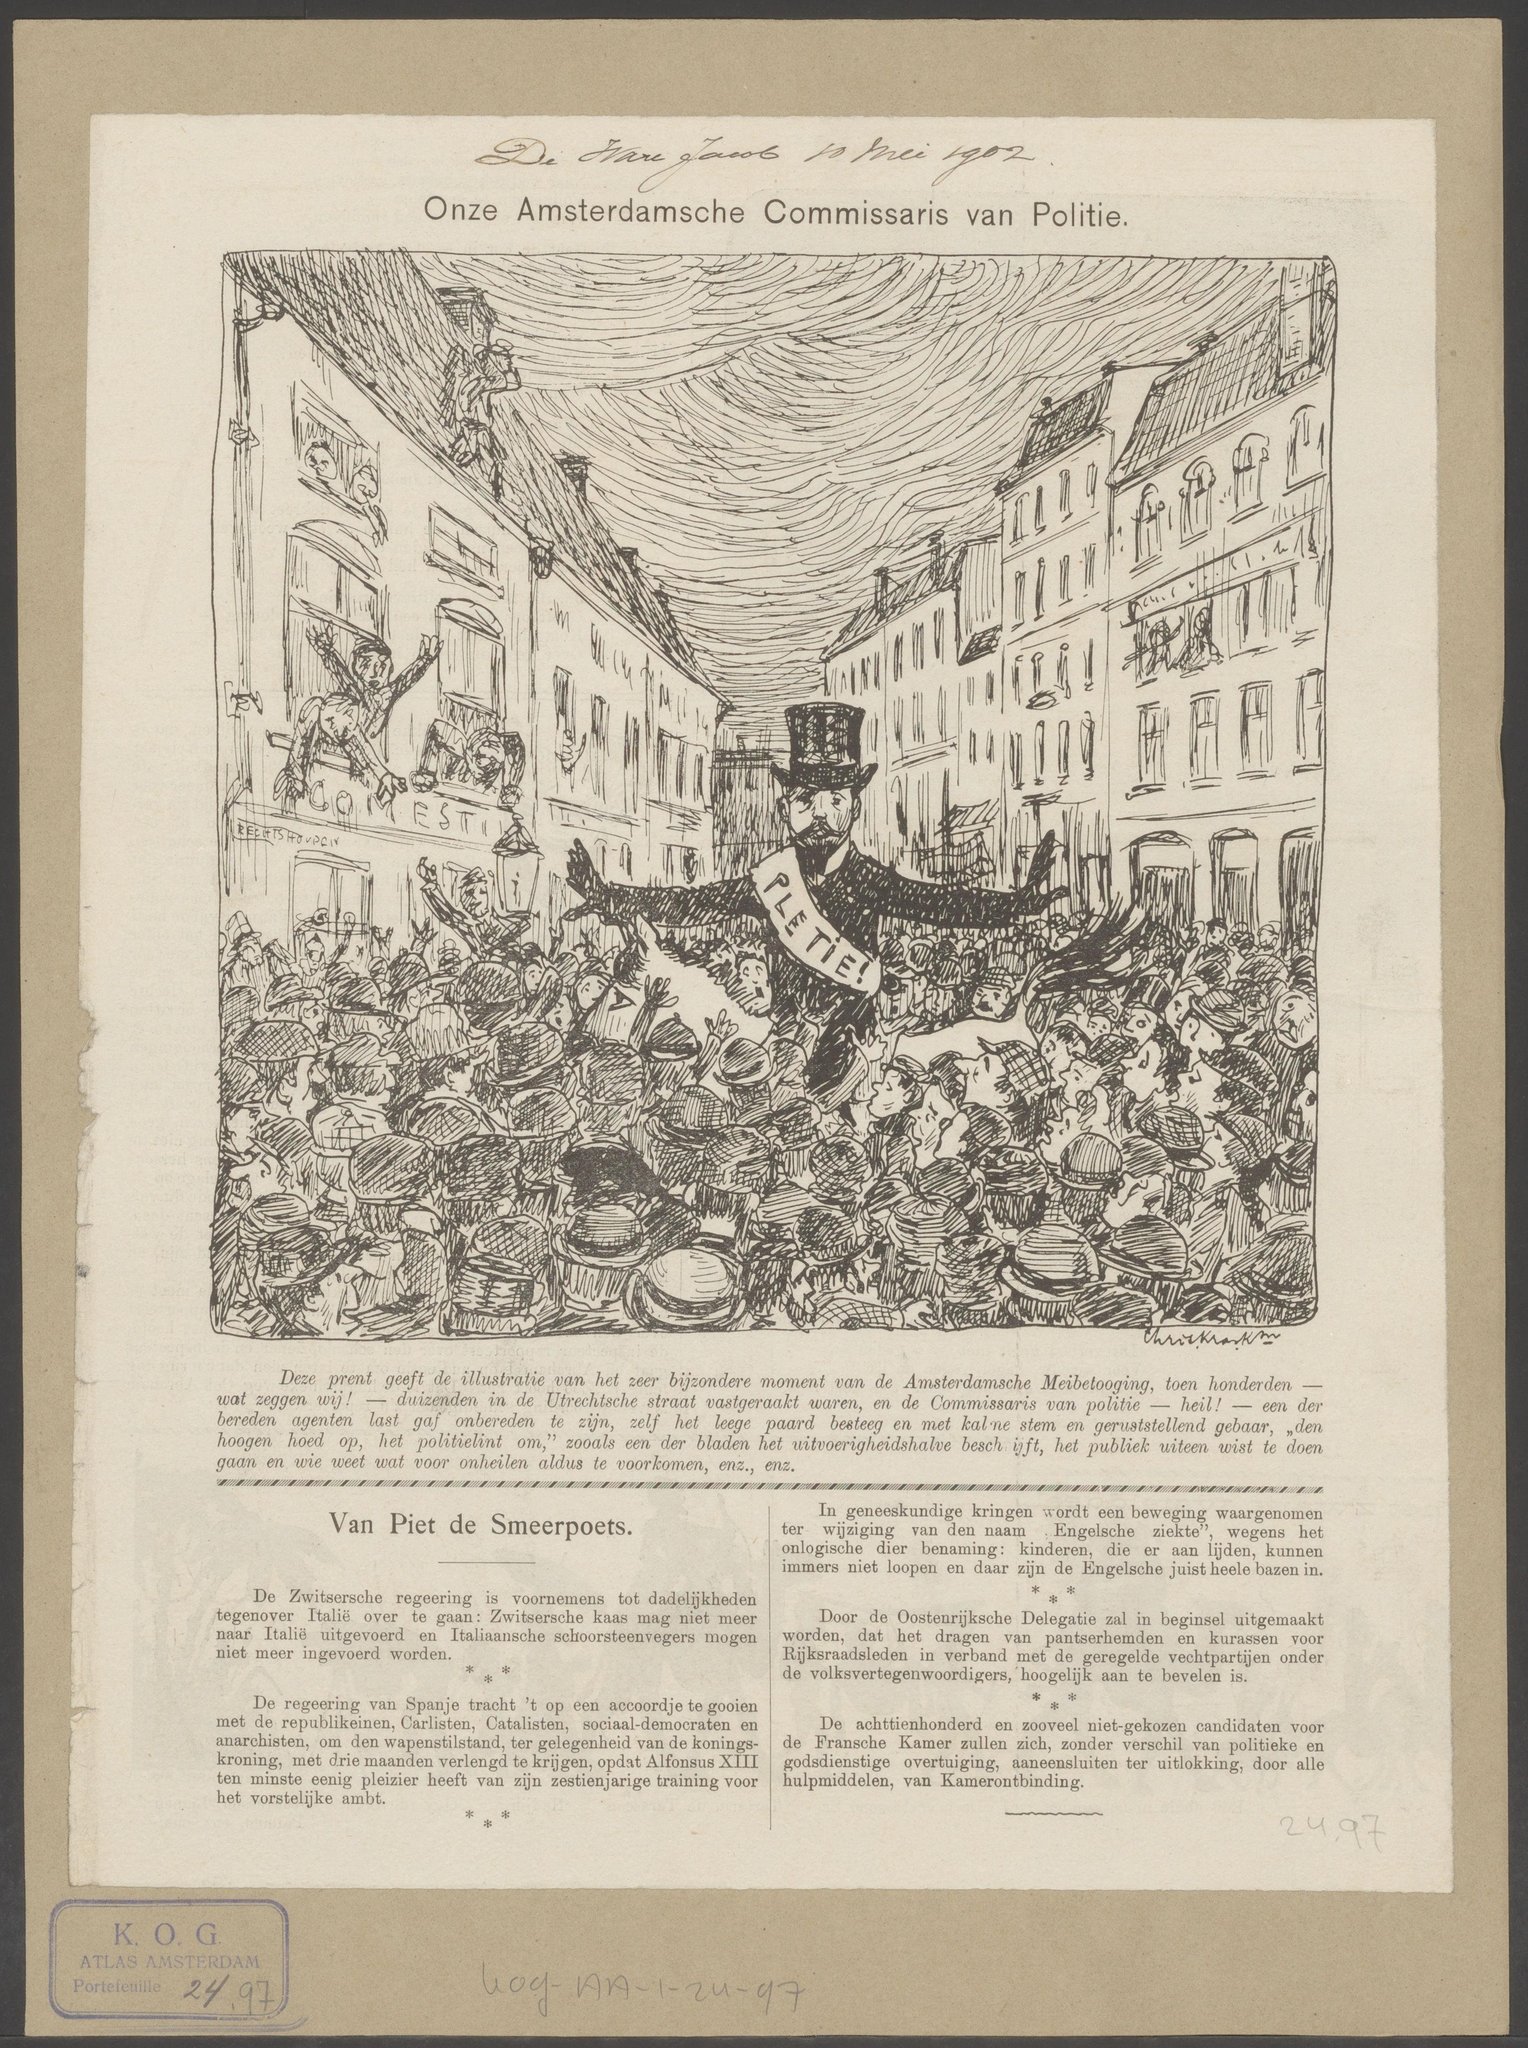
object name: photomechanical print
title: Jacobus Adrianus Franken op een paard in een menigte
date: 1902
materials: paper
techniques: letterpress printing, line block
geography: rotterdam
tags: delft, crowd, mob, horse, police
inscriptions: collector's mark: Lugt 1641b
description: Prent uit: De Ware Jacob 1 (1902), nr. 32, 10 mei 1902.